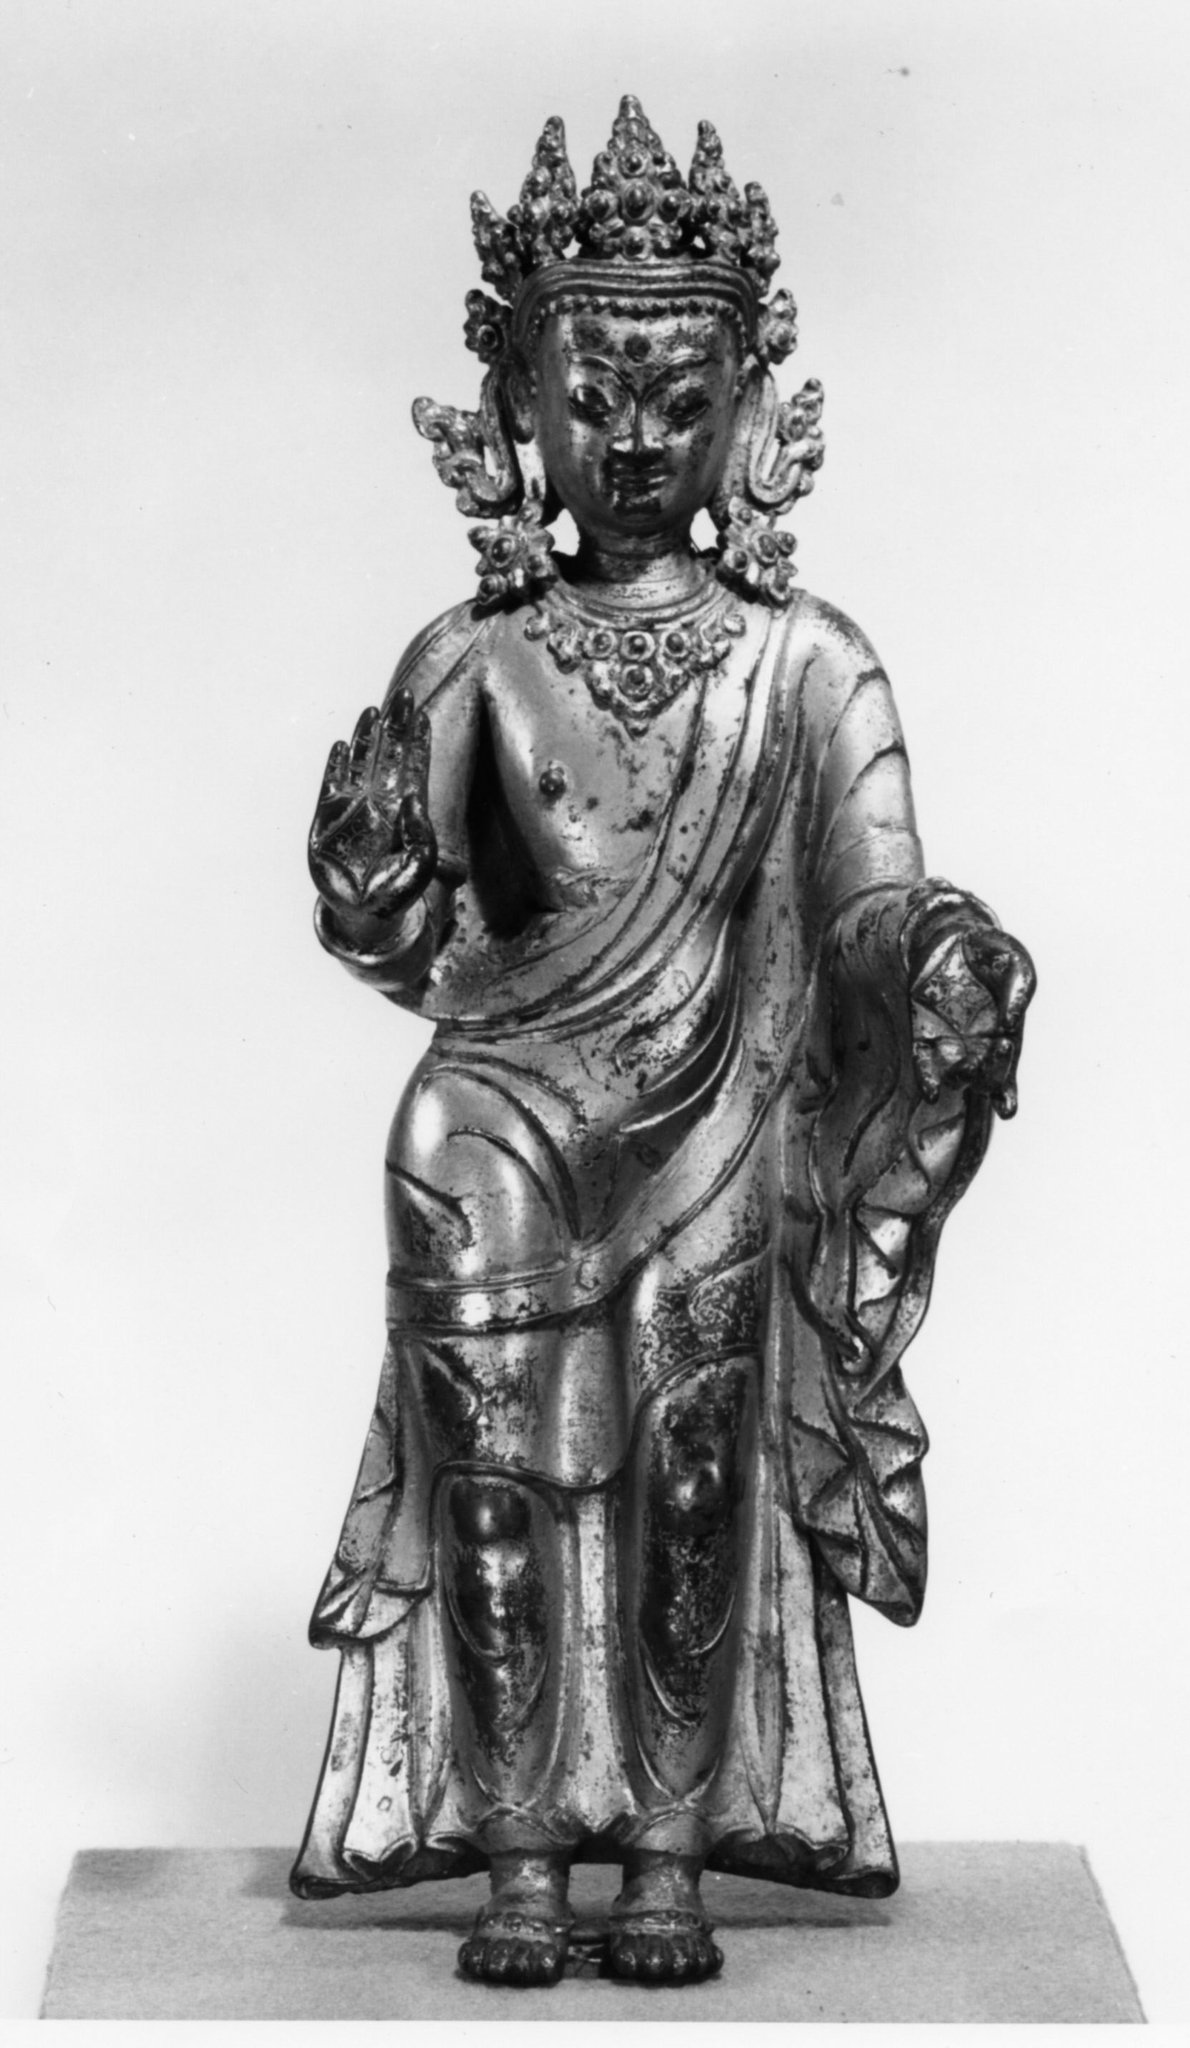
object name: figure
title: Standing Bodhisattva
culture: nepali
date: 1501-1700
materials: gilt bronze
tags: buddhism,bodhisattvas